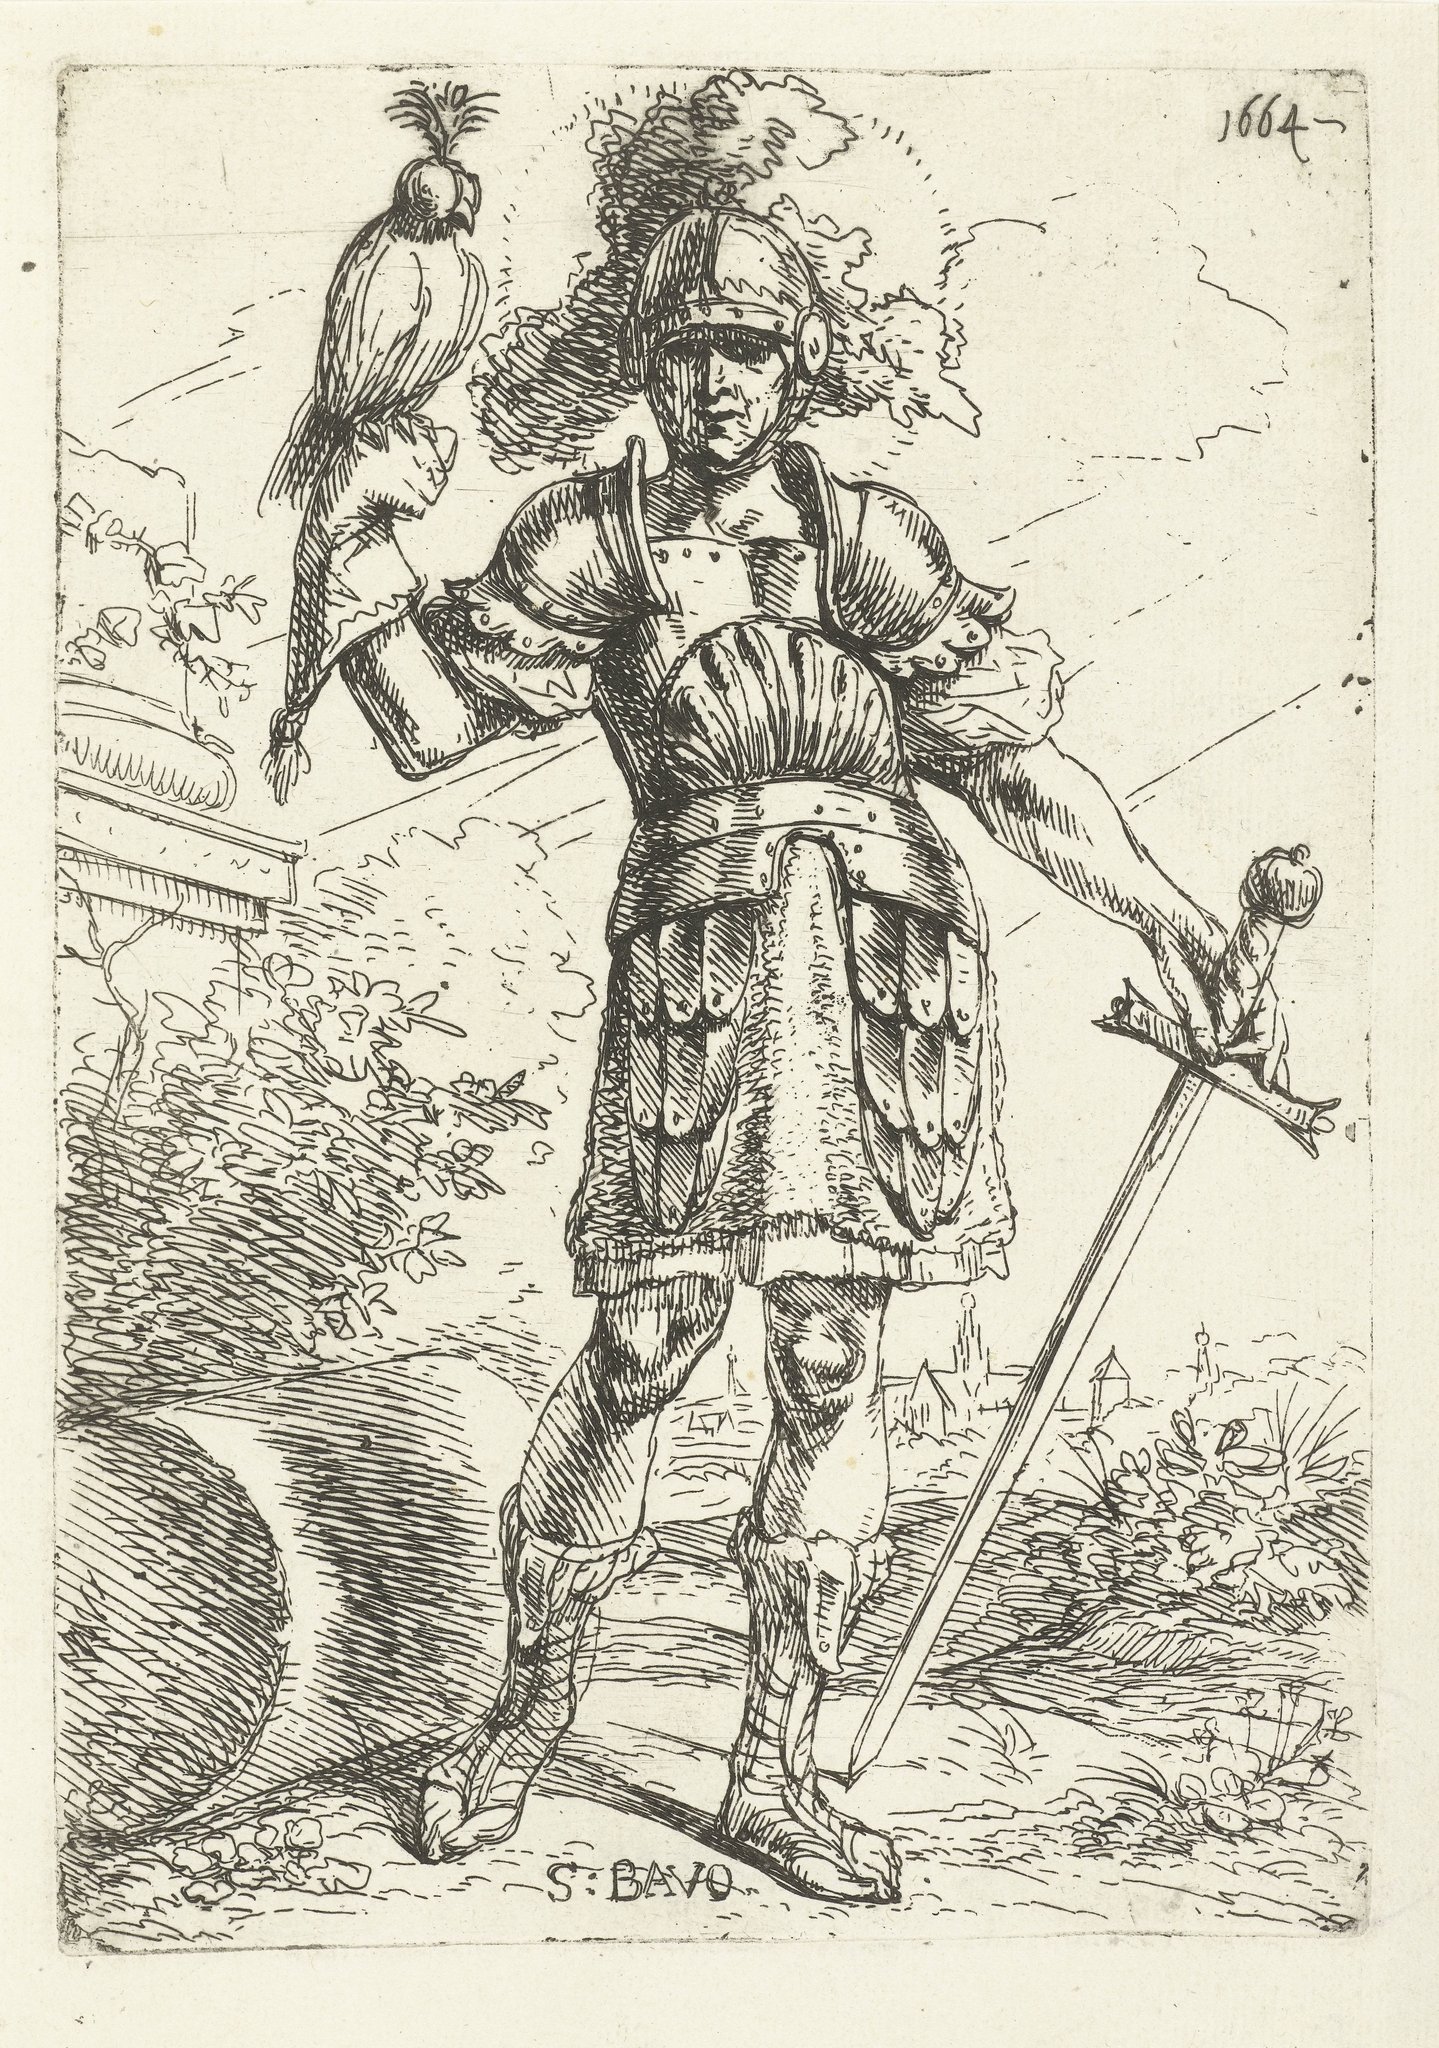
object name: print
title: H. Bavo met een valk op zijn hand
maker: leendert van der cooghen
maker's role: draughtsman, print maker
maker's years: 1632-1681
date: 1664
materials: paper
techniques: etching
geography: haarlem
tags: the hermit bavo of ghent; possible attributes: falcon, hollow tree, purse, stone, sword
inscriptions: collector's mark: Lugt 240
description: De heilige Bavo gekleed als Romeinse soldaat met een valk op zijn hand. In de andere hand een zwaard. Links Romeinse ruïnes.